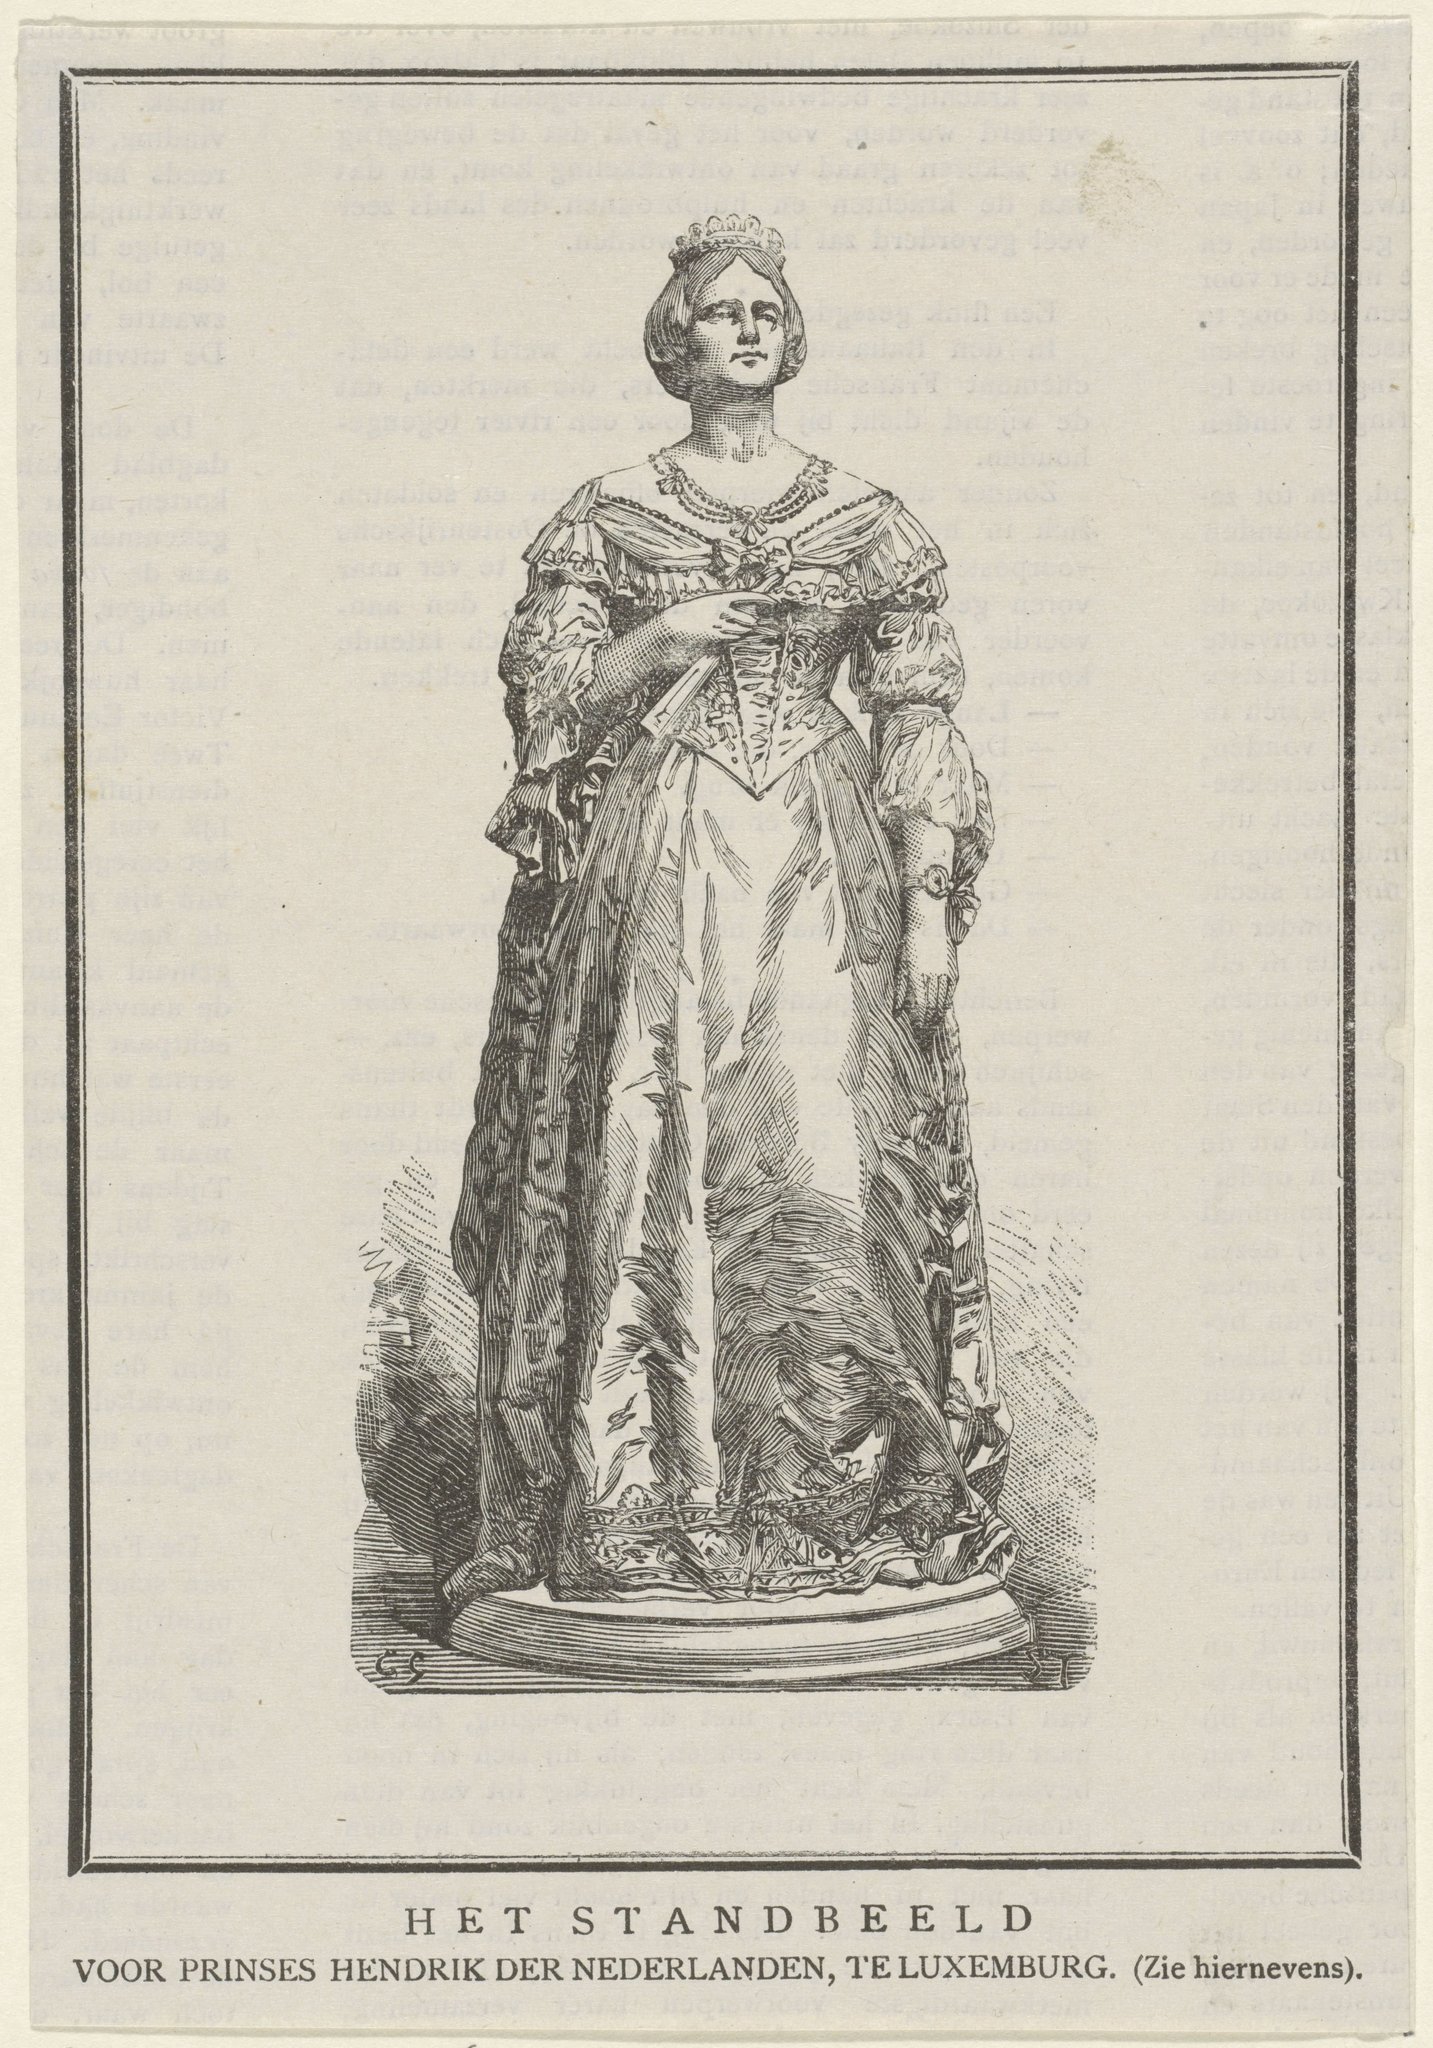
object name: print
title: Standbeeld van Maria van Pruisen te Luxemburg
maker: monogrammist cgst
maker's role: print maker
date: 1878-1949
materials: paper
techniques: letterpress printing, engraving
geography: netherlands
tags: monument, statue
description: Het standbeeld bevindt zich in Luxemburg